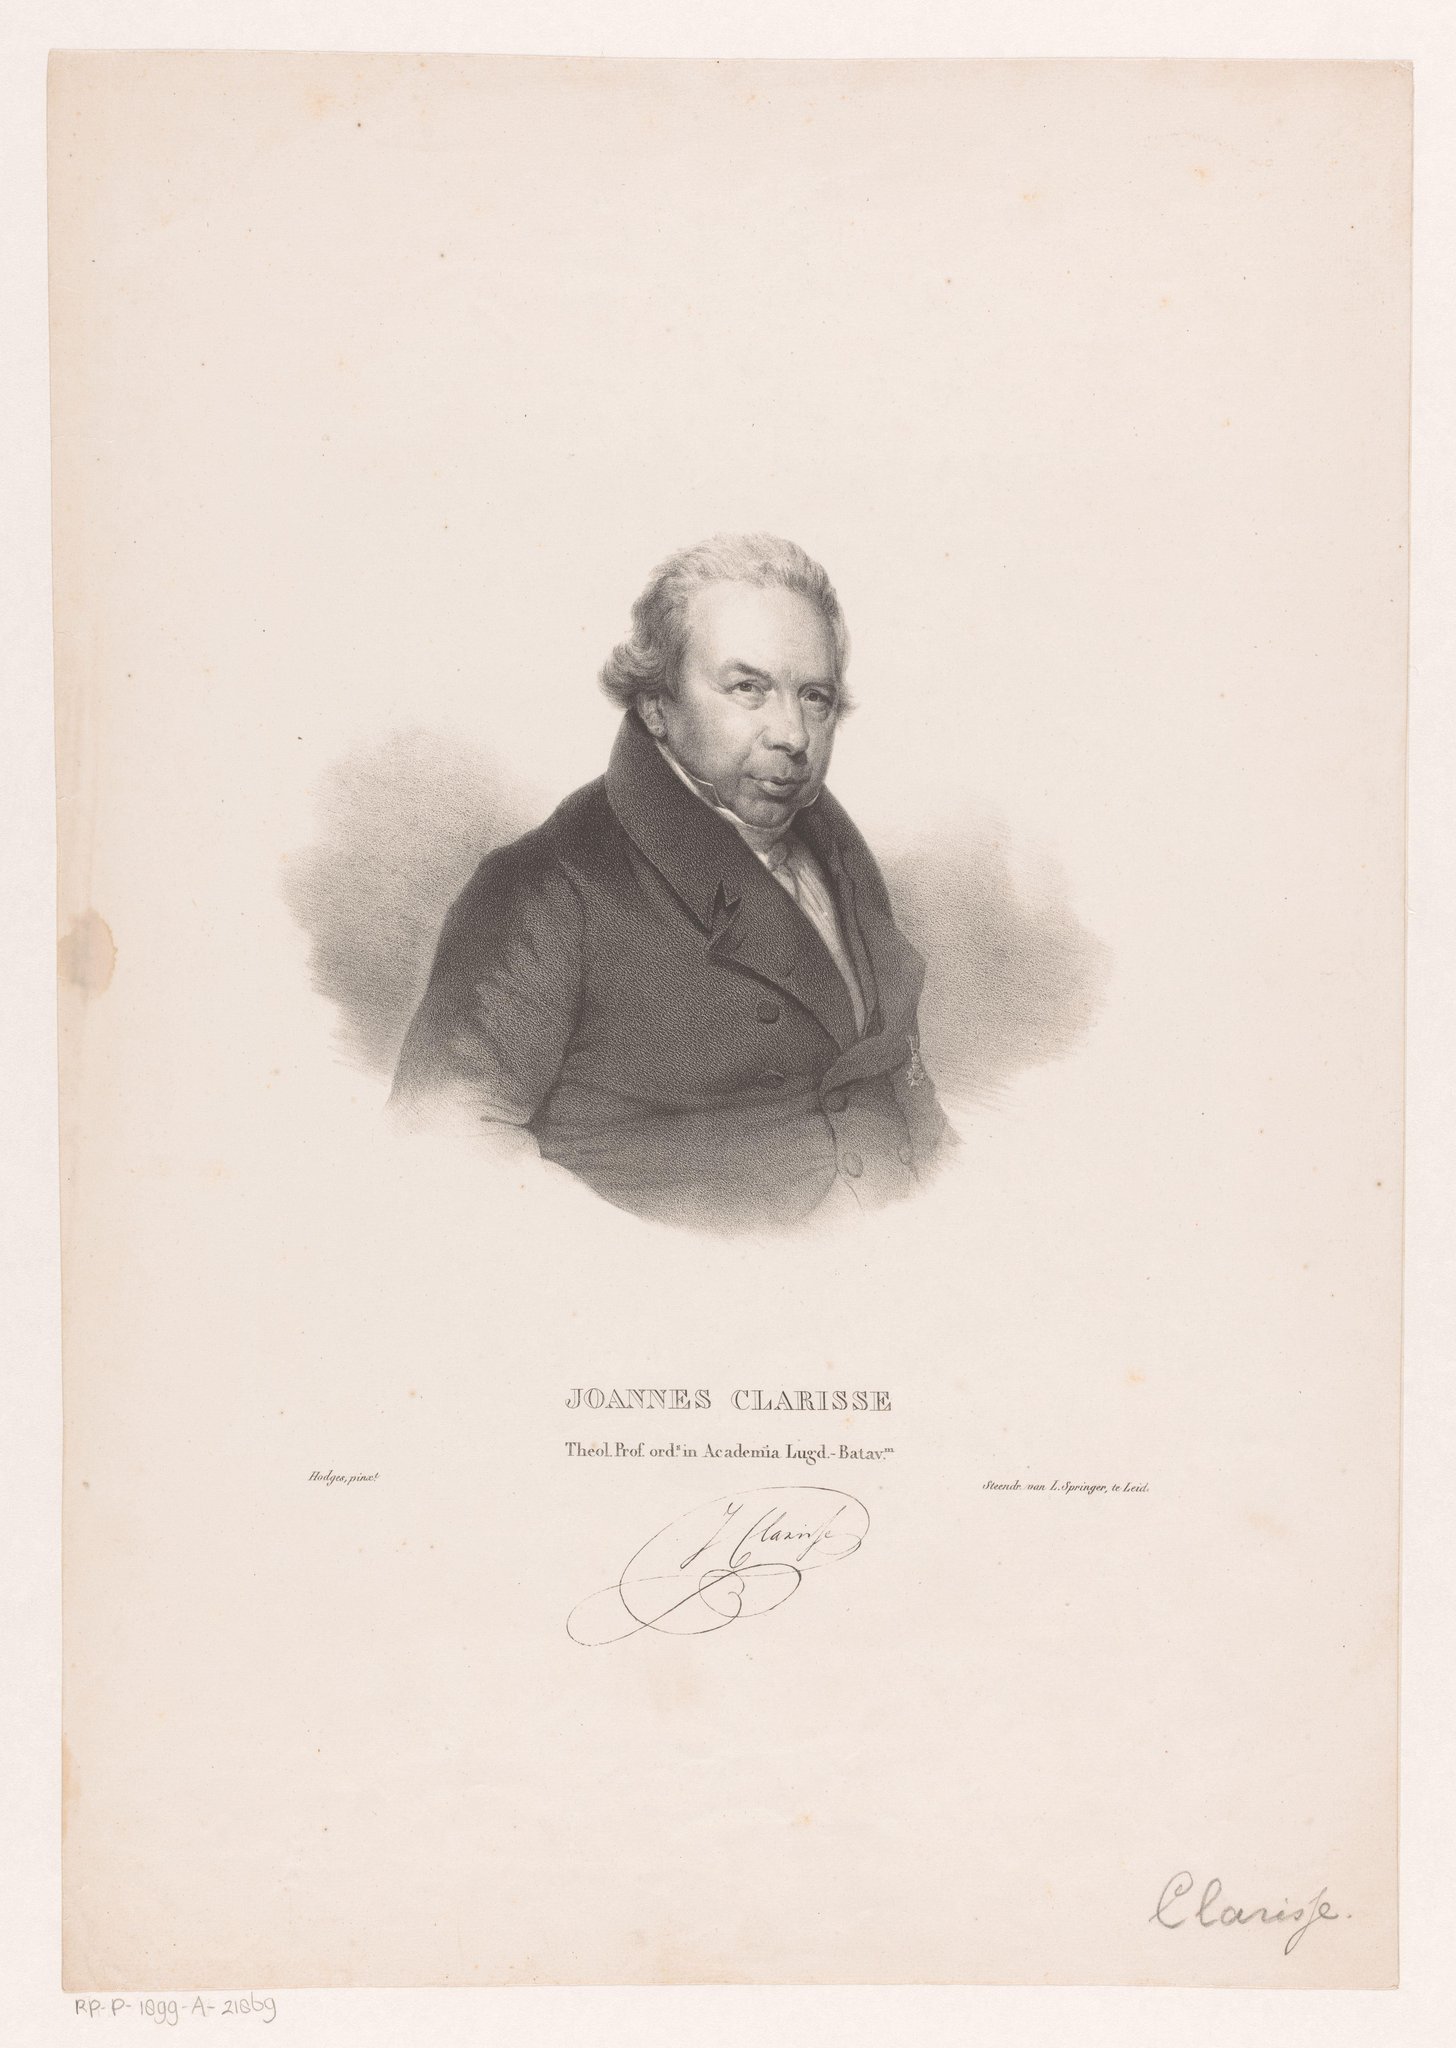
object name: print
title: Joannes Clarisse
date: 1809-1853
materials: paper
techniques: lithograph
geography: leiden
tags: rhenen, historical persons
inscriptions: collector's mark: Lugt 2228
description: Onder het portret de signatuur van de geportretteerde.